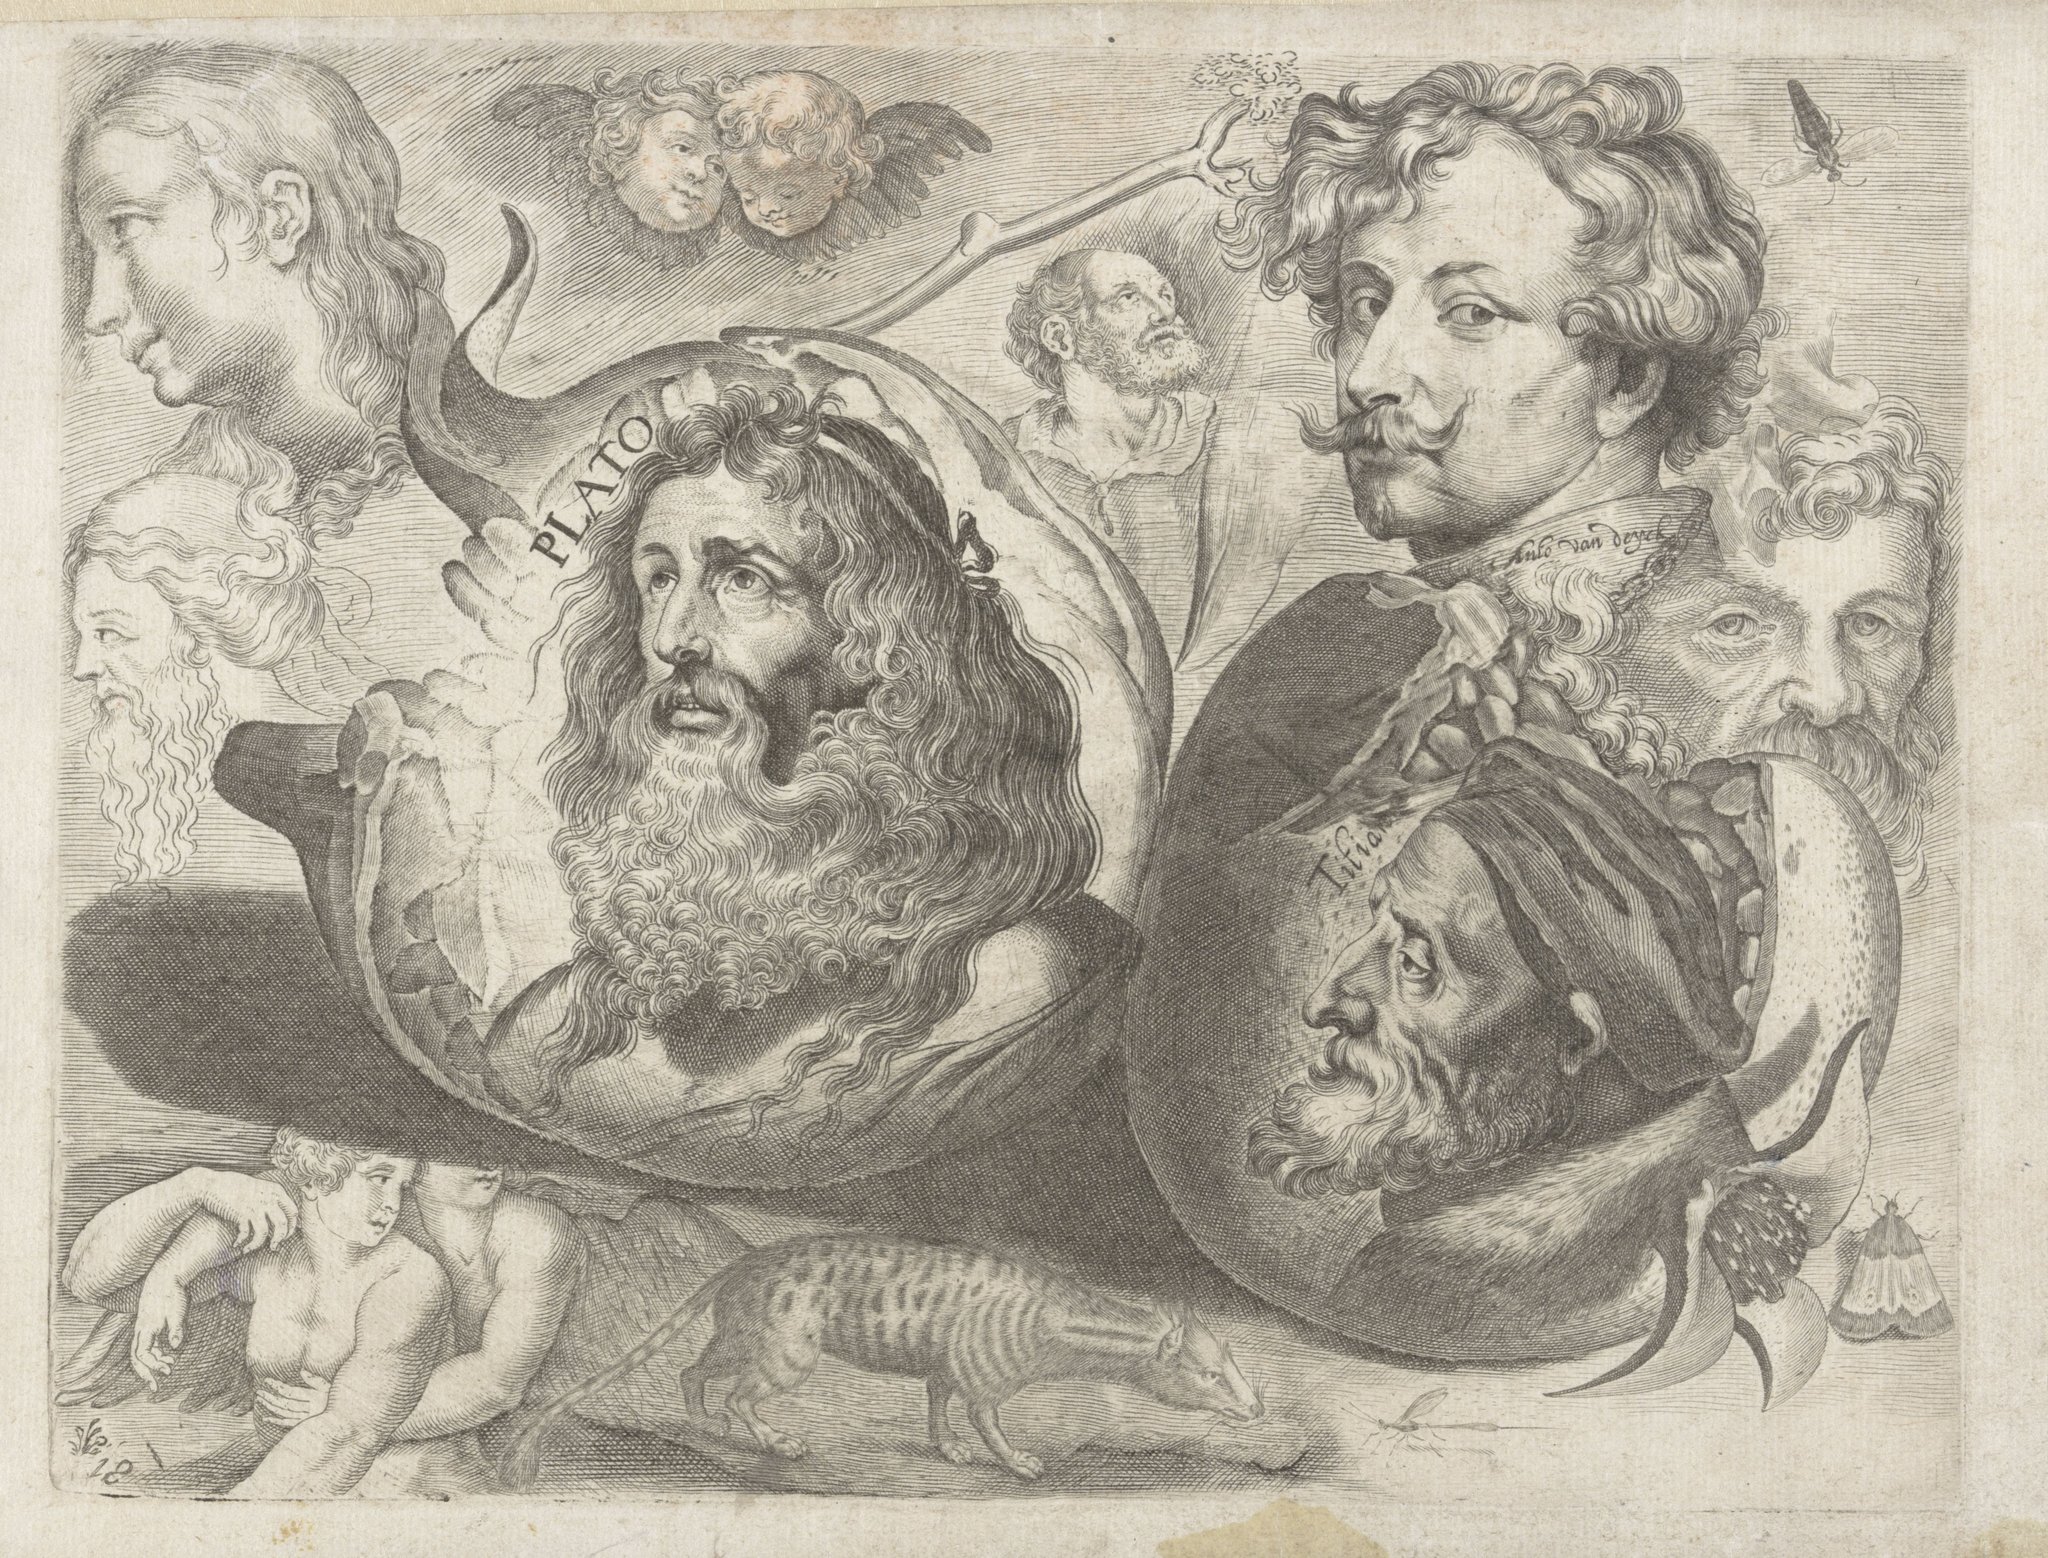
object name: print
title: Tekenvoorbeelden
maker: michael snijders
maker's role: print maker, publisher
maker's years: 1586-1672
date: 1610-1672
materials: paper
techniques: engraving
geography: antwerp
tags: venice, painter, draughtsman, titiaan, anthony van dyck, head (human), model-books ~ implements of painter, fruits: pomegranate, insects, beasts of prey, predatory animals: civet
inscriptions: signature and date: ‘L.O. GENUMMERD 18’, collector's mark: Lugt 2228, inscription: ‘PLATO (bij kop Plato); Titiaan (bij kop Titiaan); Anto Van deijck (bij kop Van Dijck). L.o. genummerd: 18’, collector's mark: Lugt 3751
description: Achttiende prent uit een serie met tekenvoorbeelden. Studieblad met koppen, figuren en dieren. In het midden links portret van Plato en rechtsboven portret van Anthony van Dyck, daaronder portret van Titiaan. Daaromheen diverse insecten, dieren, figuren waaronder een civet.